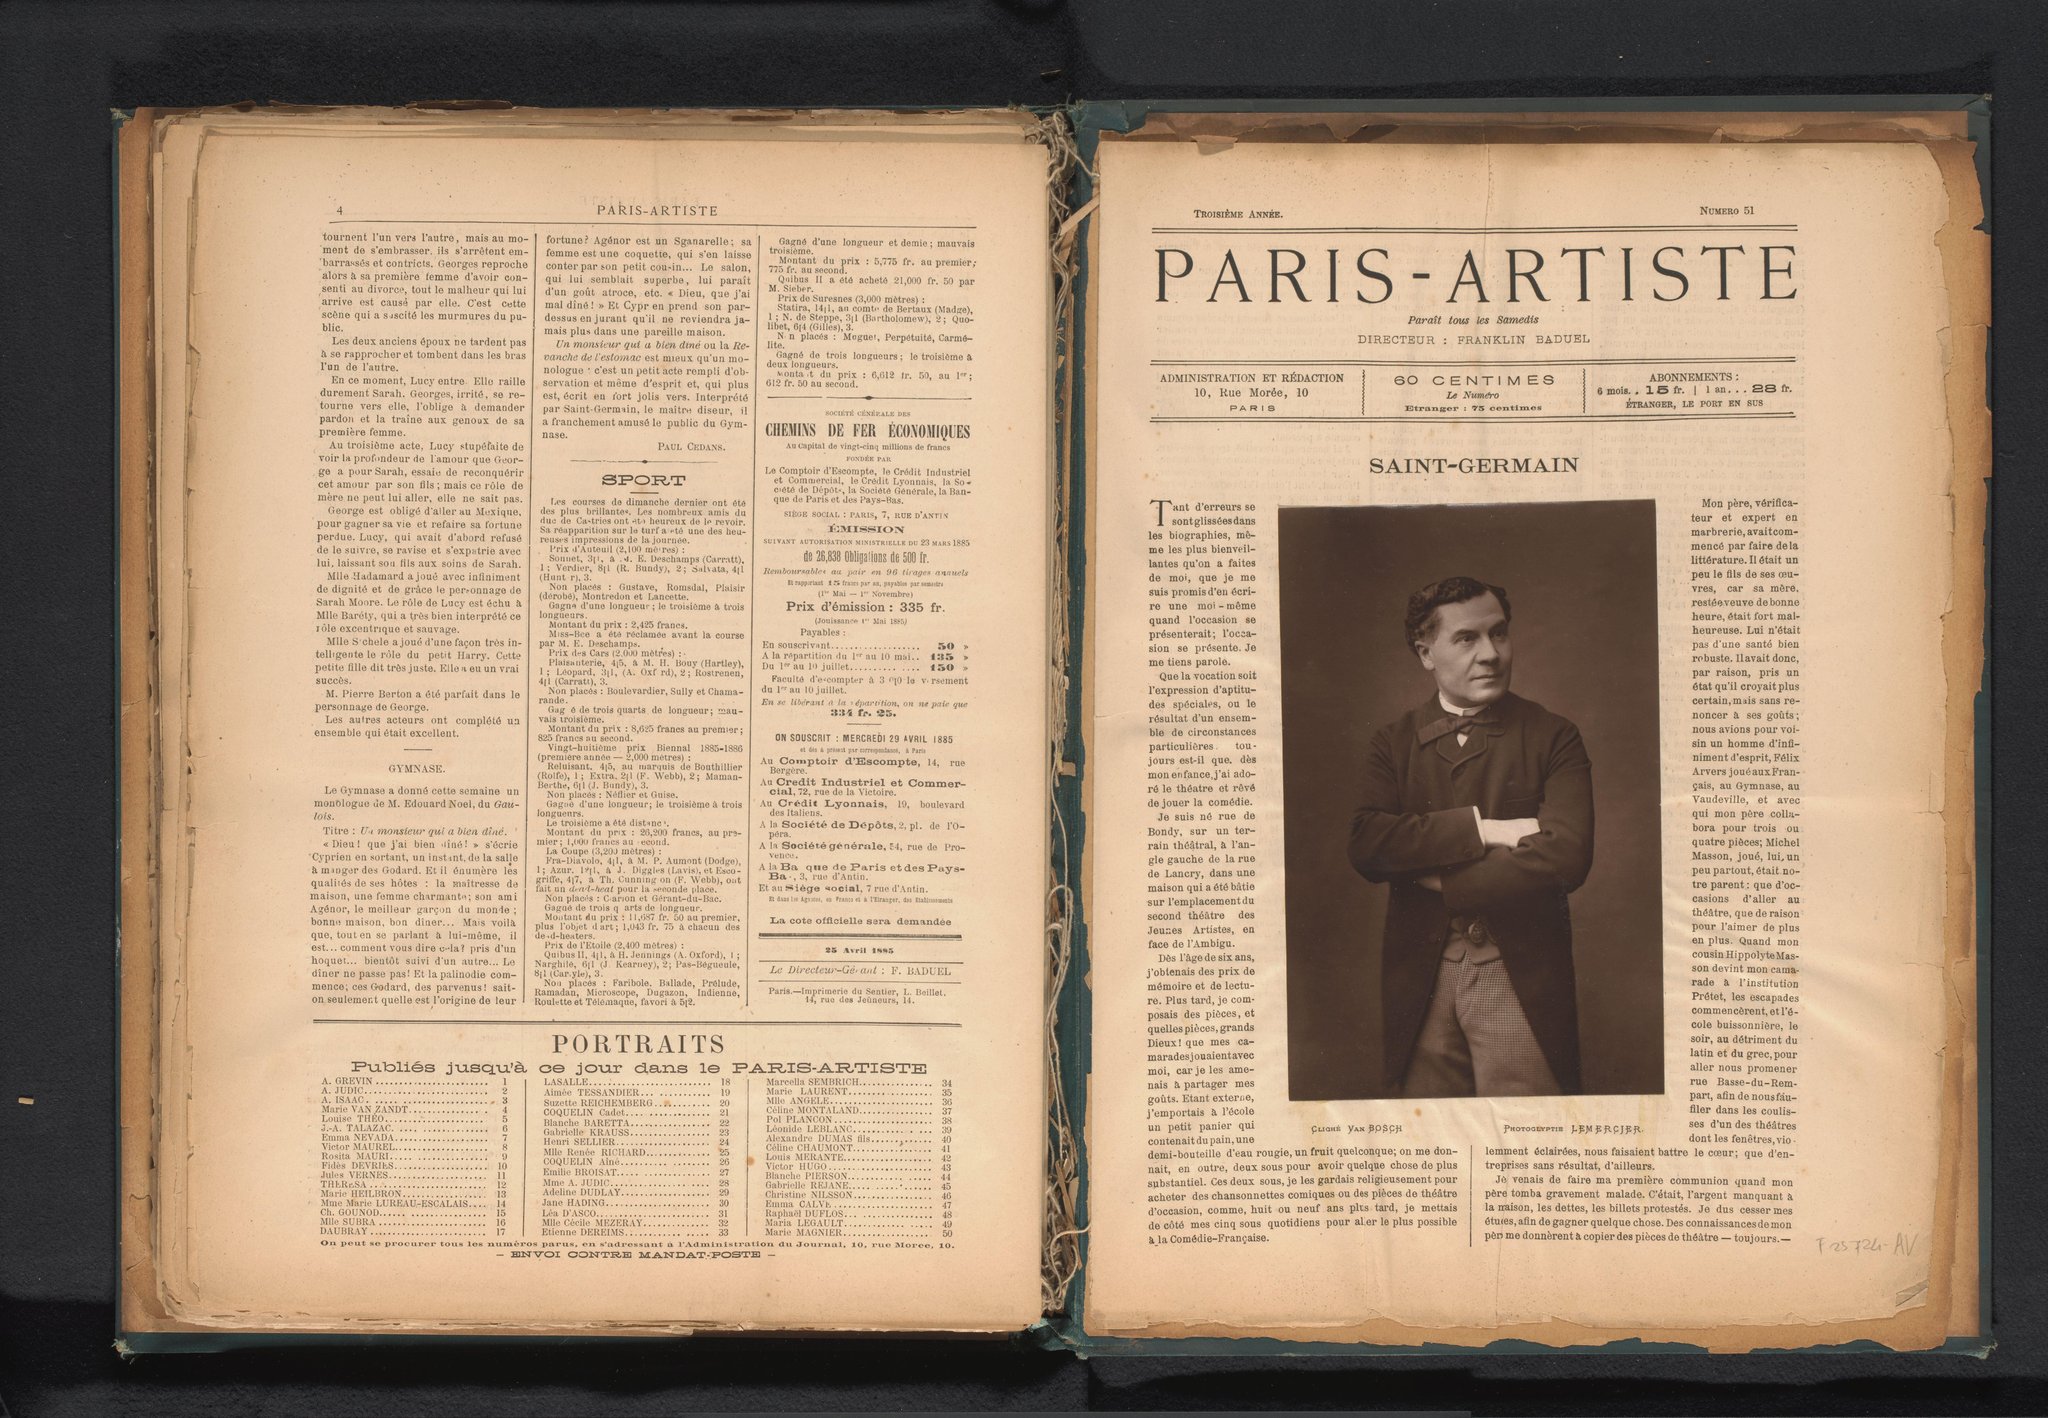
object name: photomechanical print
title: Portret van Gilles de Saint-Germain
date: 1880-1885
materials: paper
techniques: woodburytype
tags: historical persons, portrait of actor, actress